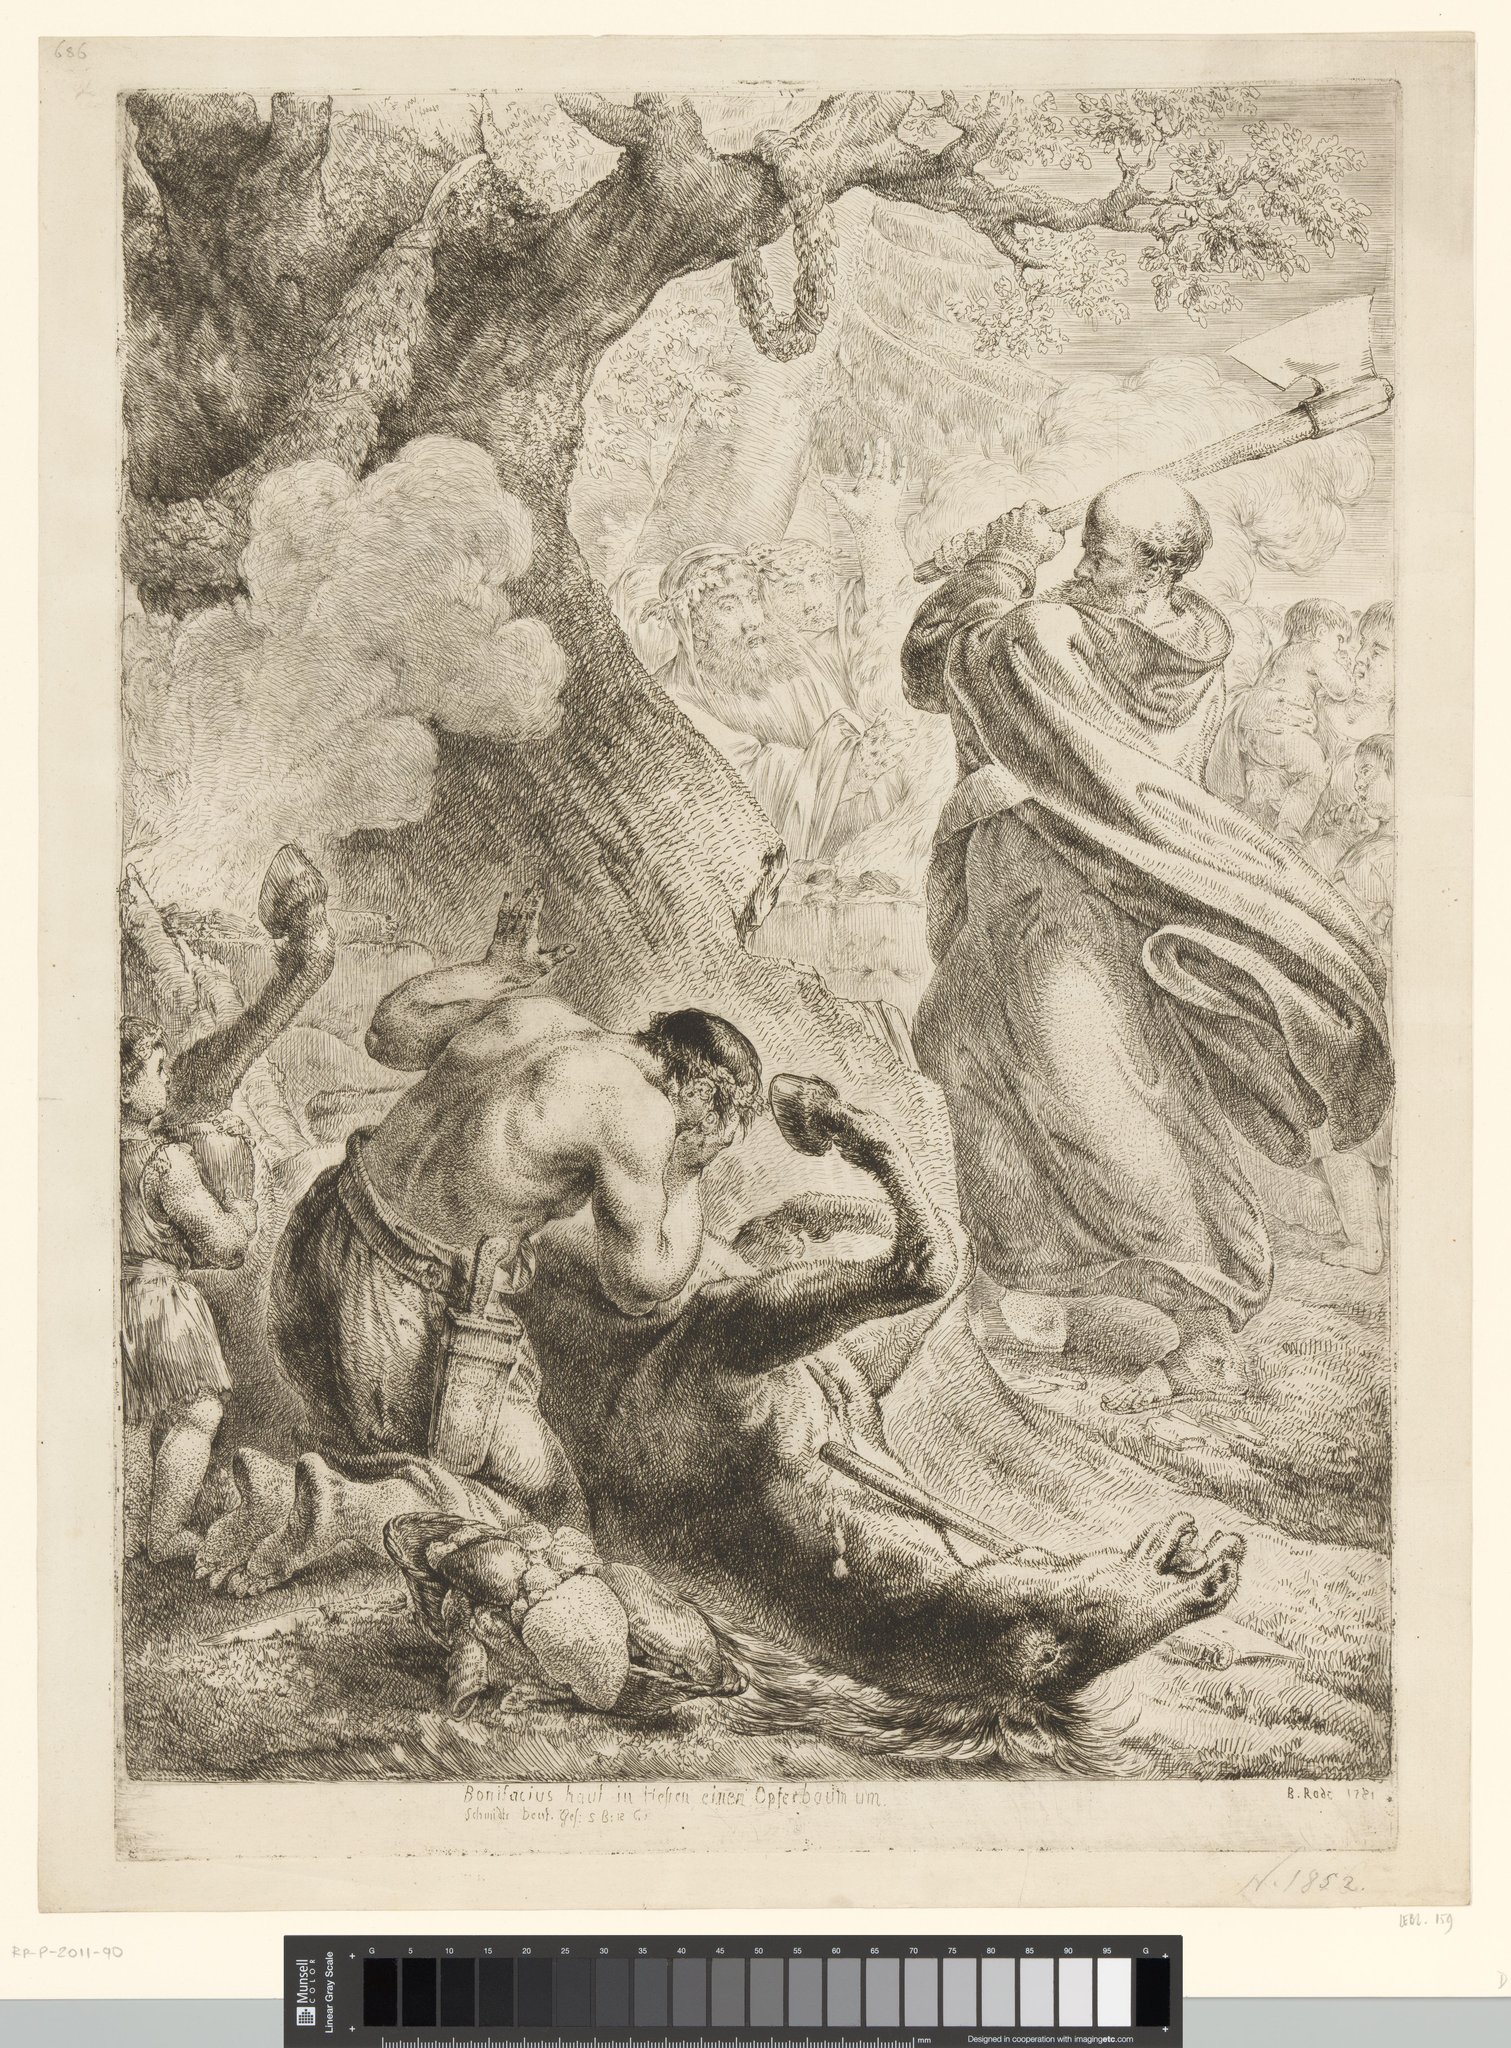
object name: print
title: Bonifacius hauf in Hessen einen Opferbaum um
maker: bernhard rode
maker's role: artist, print maker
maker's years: 1725-1797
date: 1781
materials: paper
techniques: etching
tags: st. boniface cutting down an oak-tree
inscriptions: collector's mark: Lugt 2228, collector's mark: Lugt 2760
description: Sint Bonifatius hakt met een bijl een heilige, met kransen behangen eik om. Op de voorgrond knielt een man bij een dood (geofferd?) paard en bedekt zijn gezicht met zijn hand. In de achtergrond een aantal Germaanse priesters rond een altaar met offervuur en een vrouw met kleine kinderen.